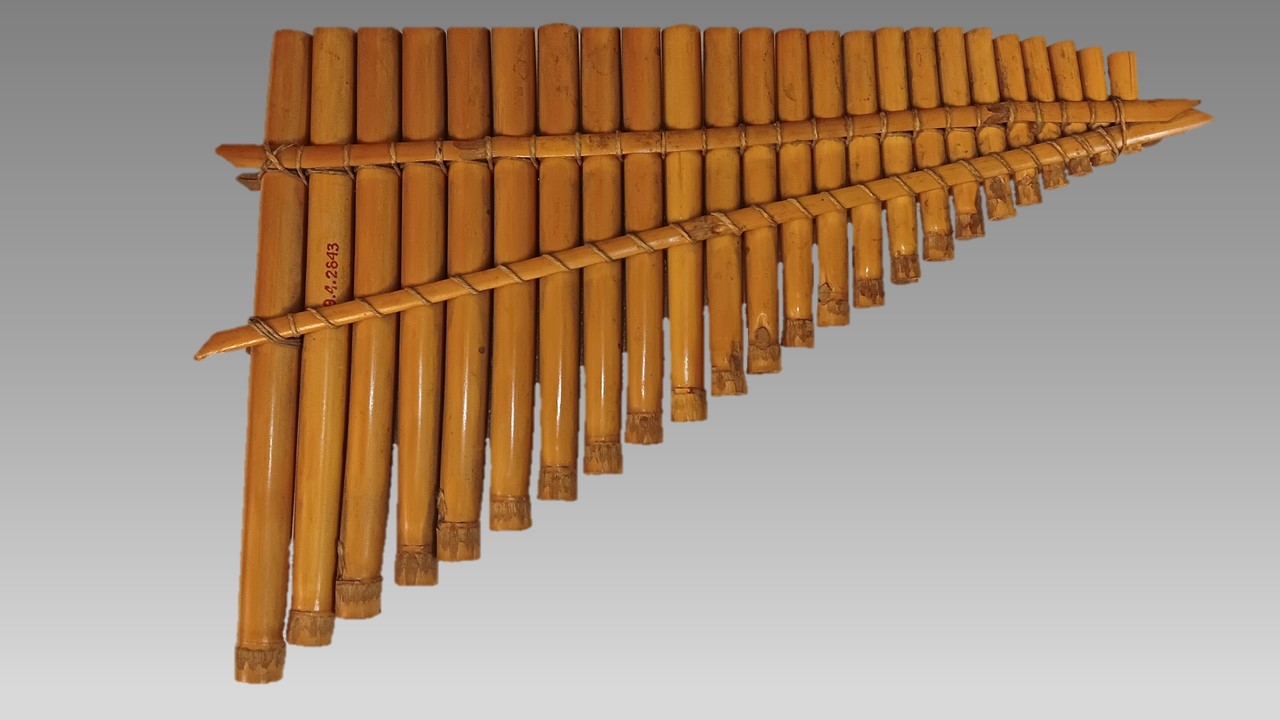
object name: sa fa kir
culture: egyptian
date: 1865-1889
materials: bamboo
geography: egypt